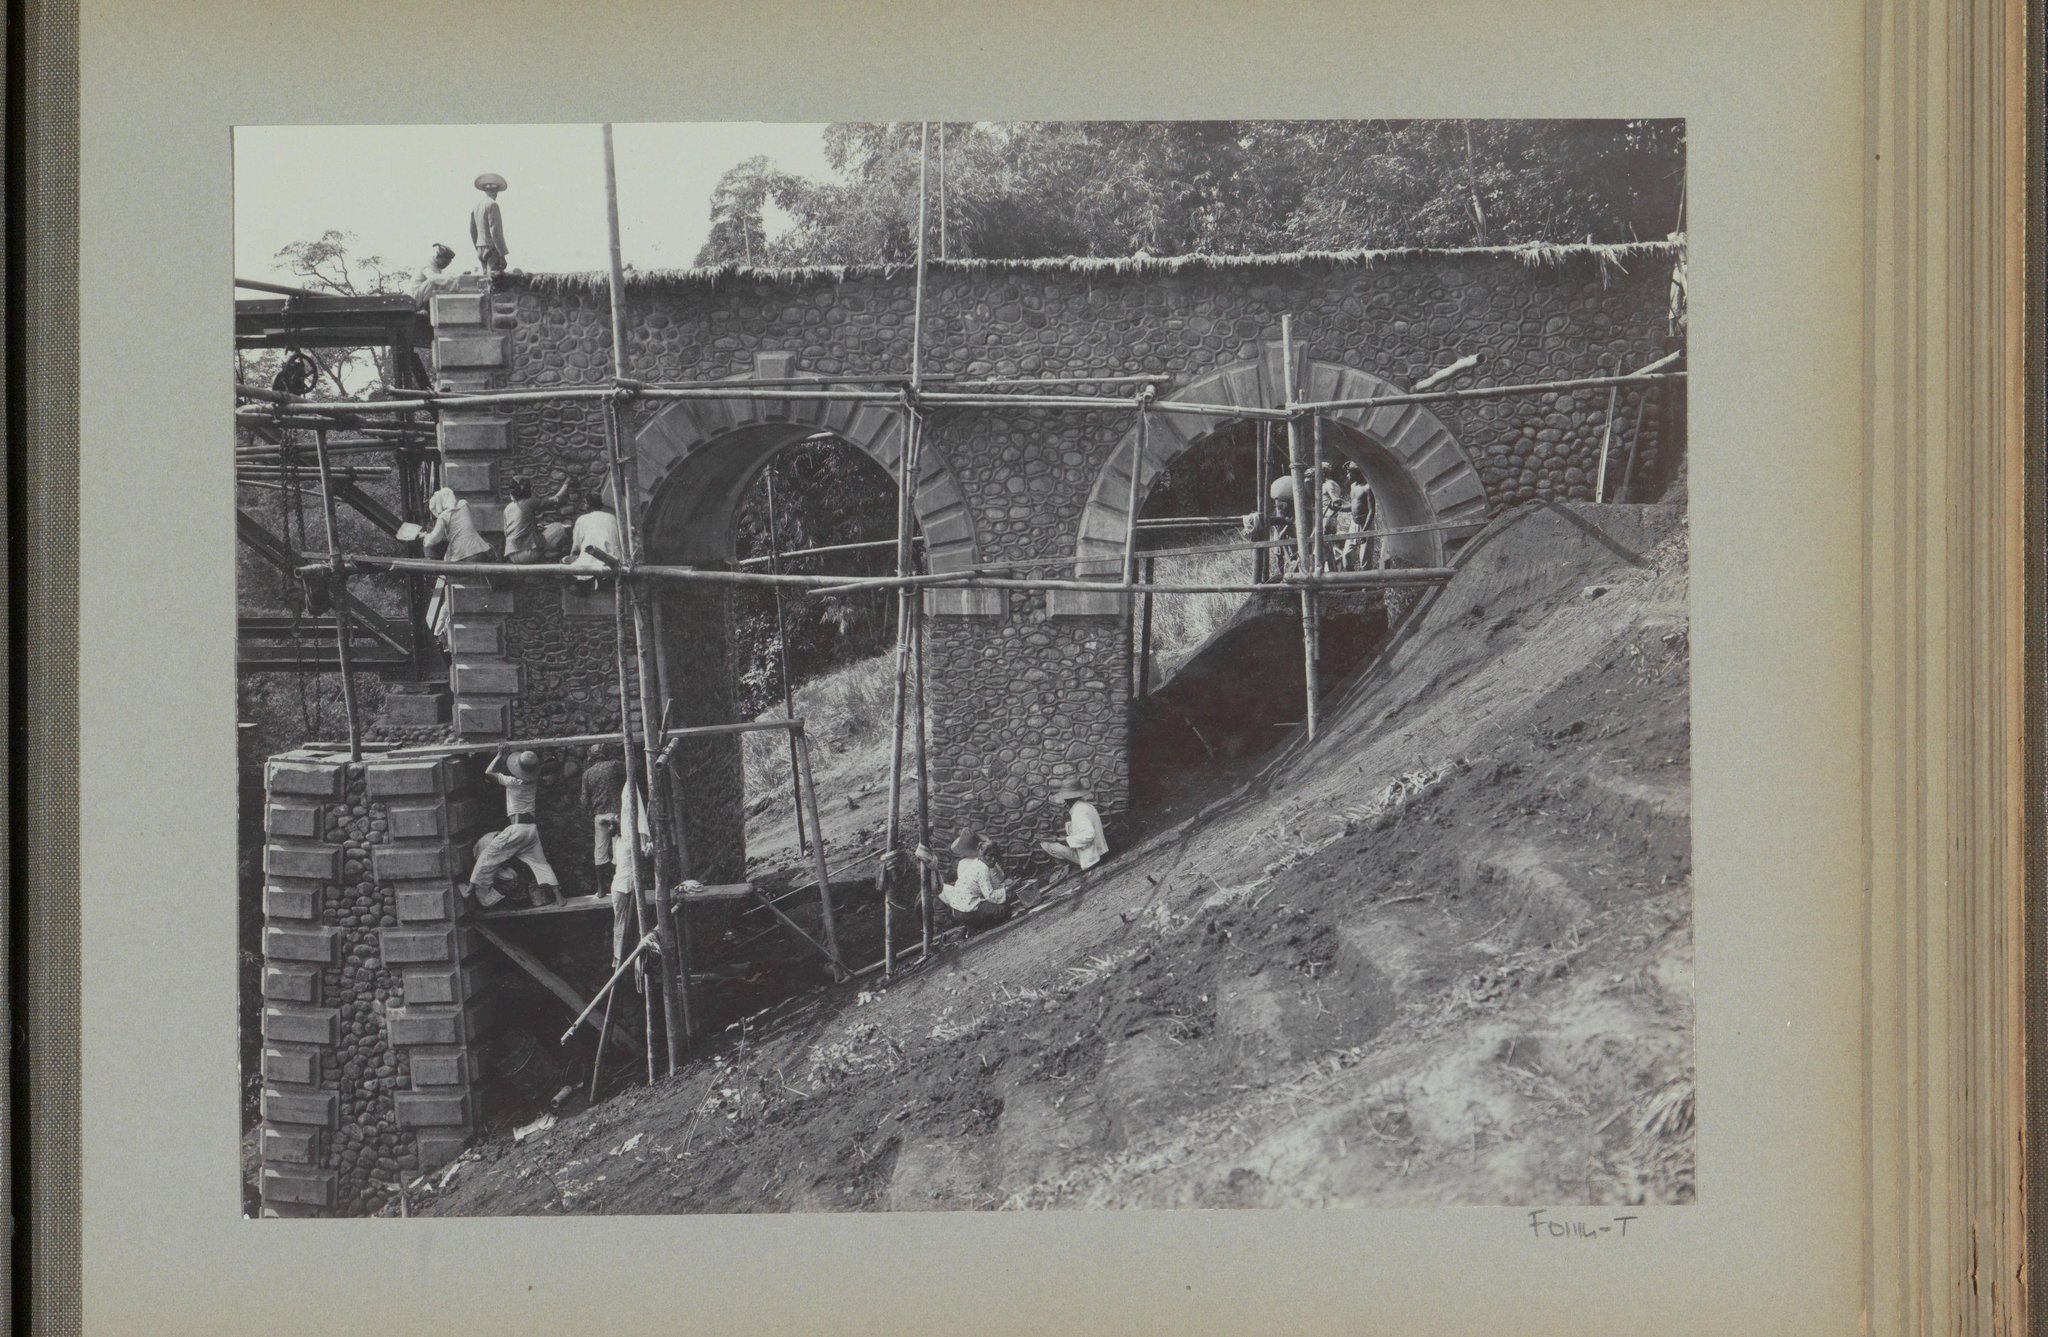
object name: album leaf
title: Metselarbeid aan gereed landhoofd op de westelijke oever van de Kali Brantas ten zuiden van Malang (Photo XX)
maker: Anonymous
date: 1890-1920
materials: cardboard, paper, photographic support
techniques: gelatin silver print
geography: java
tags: engineering, landscape with bridge, viaduct or aqueduct, mason at work, bridge, building-site, java, dutch east indies, the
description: Foto met op de linkerpagina het bijbehorende bijschrift. Onderdeel van Fotoalbum met opnames van de bouw van een brug over de Kali Brantas ten zuiden van Malang op Java.